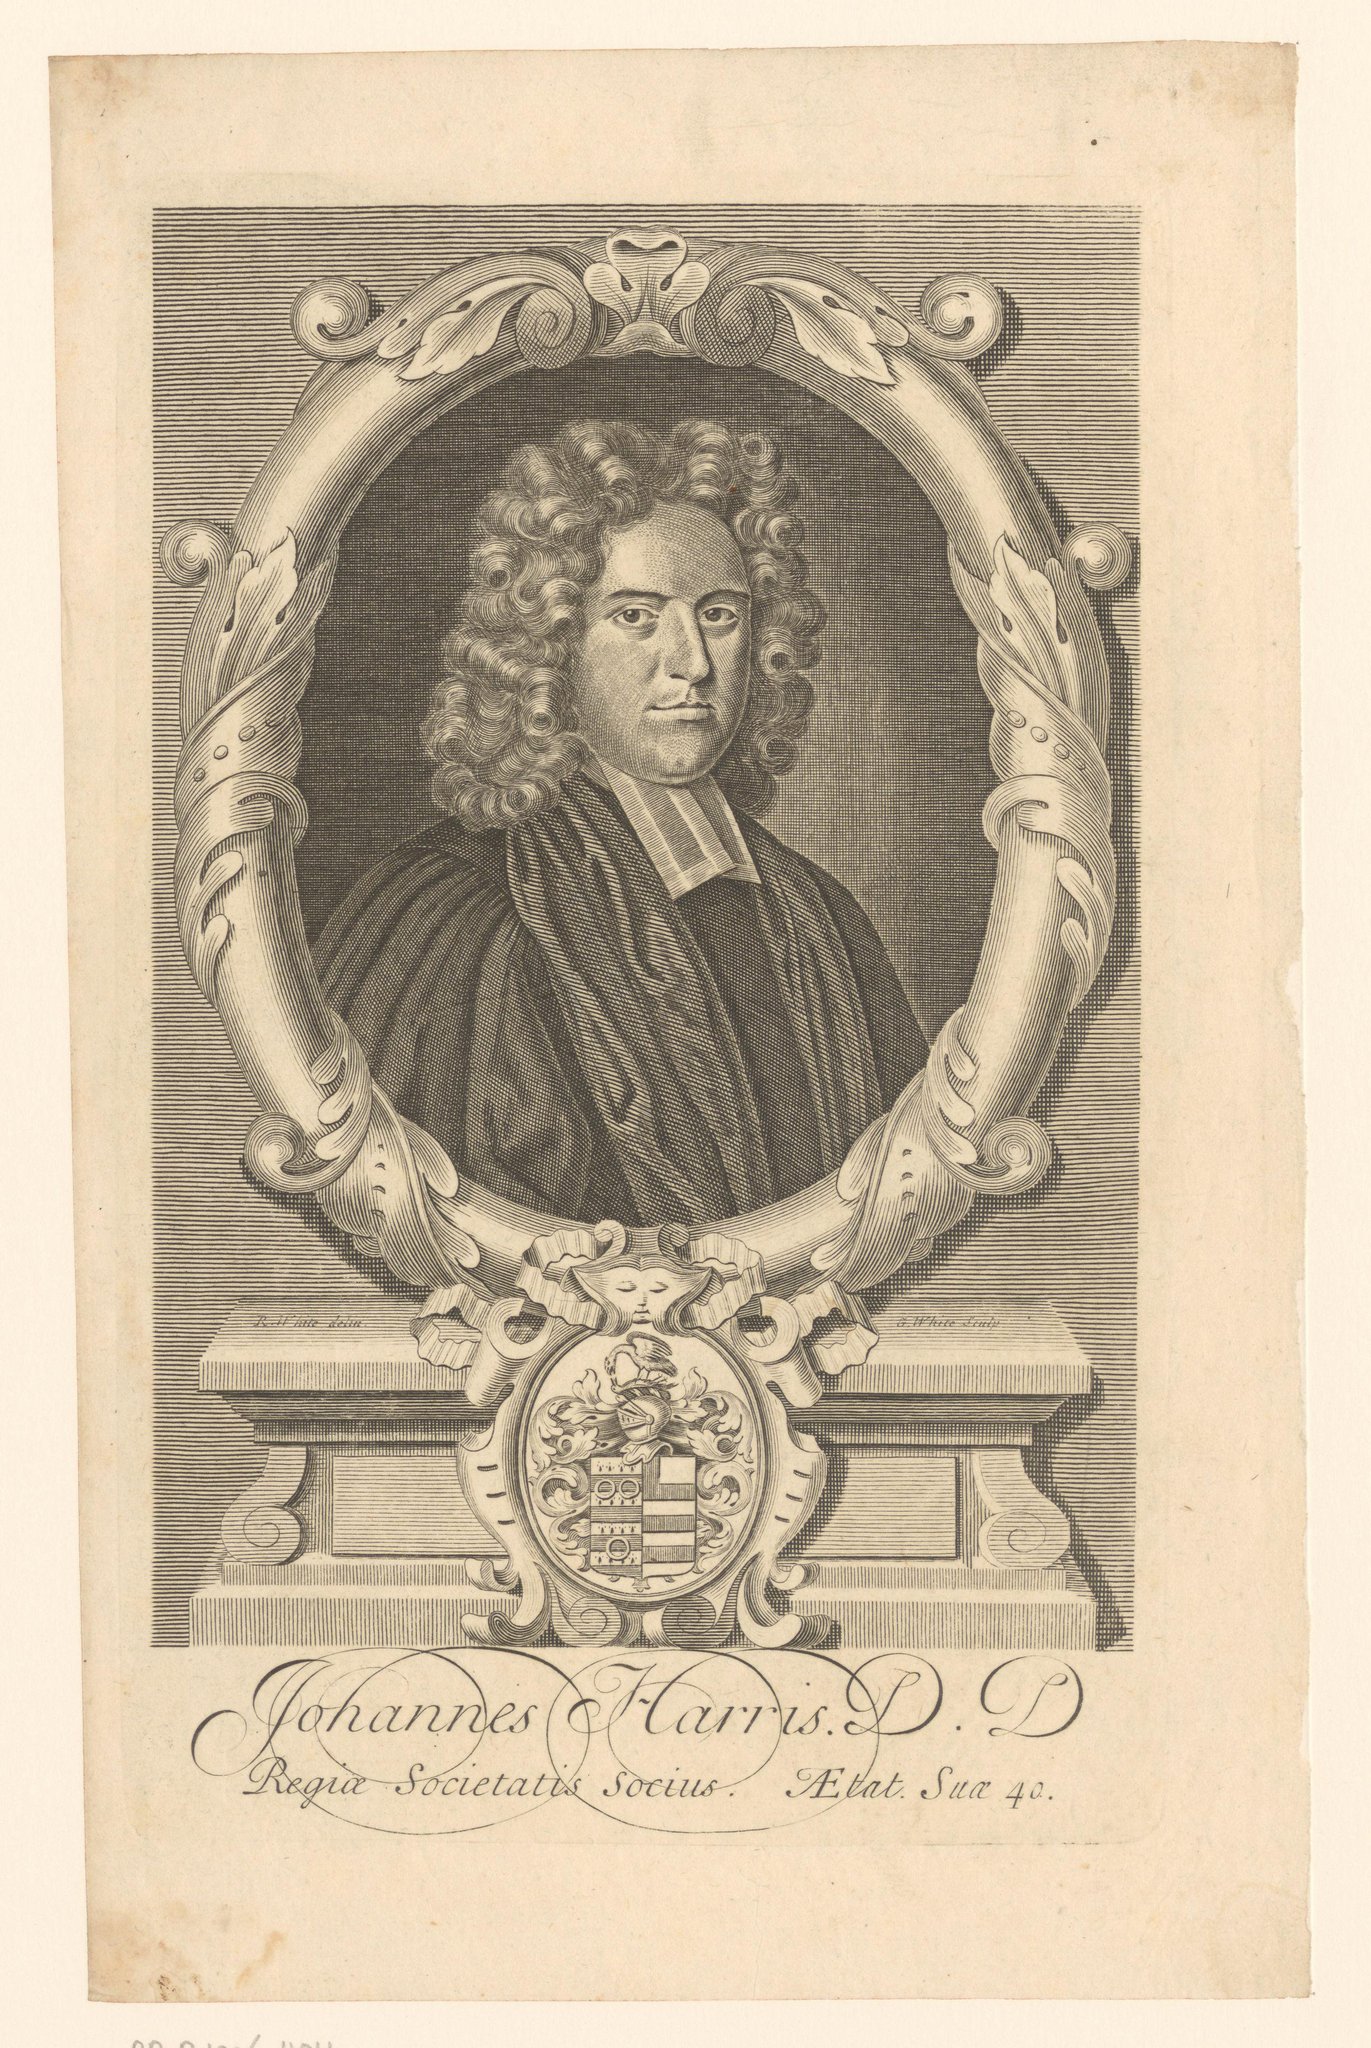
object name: print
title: Johannes Harris D.D.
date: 1706-1708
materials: paper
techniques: engraving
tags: priest, historical persons, portrait of a writer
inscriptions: collector's mark: Lugt 2228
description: Eerdere staat gebruikt in: Harris, John. Lexicon Technicum, or, an universal English dictionary of Arts and Sciences (...). Londen: Brown, Dan. et al., 1704.